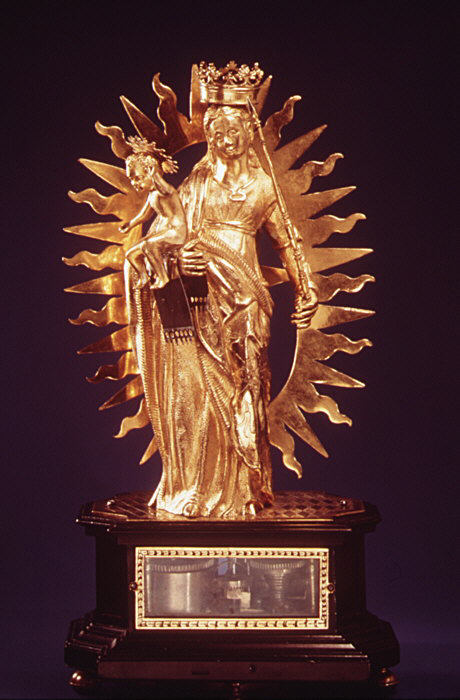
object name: automaton clock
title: Automaton clock in the form of the Madonna and Child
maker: nikolaus schmidt the elder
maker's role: maker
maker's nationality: german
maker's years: 1545-1630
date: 1620-1625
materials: brass, wood, gilt brass, iron, silver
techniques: veneering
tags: madonna and child